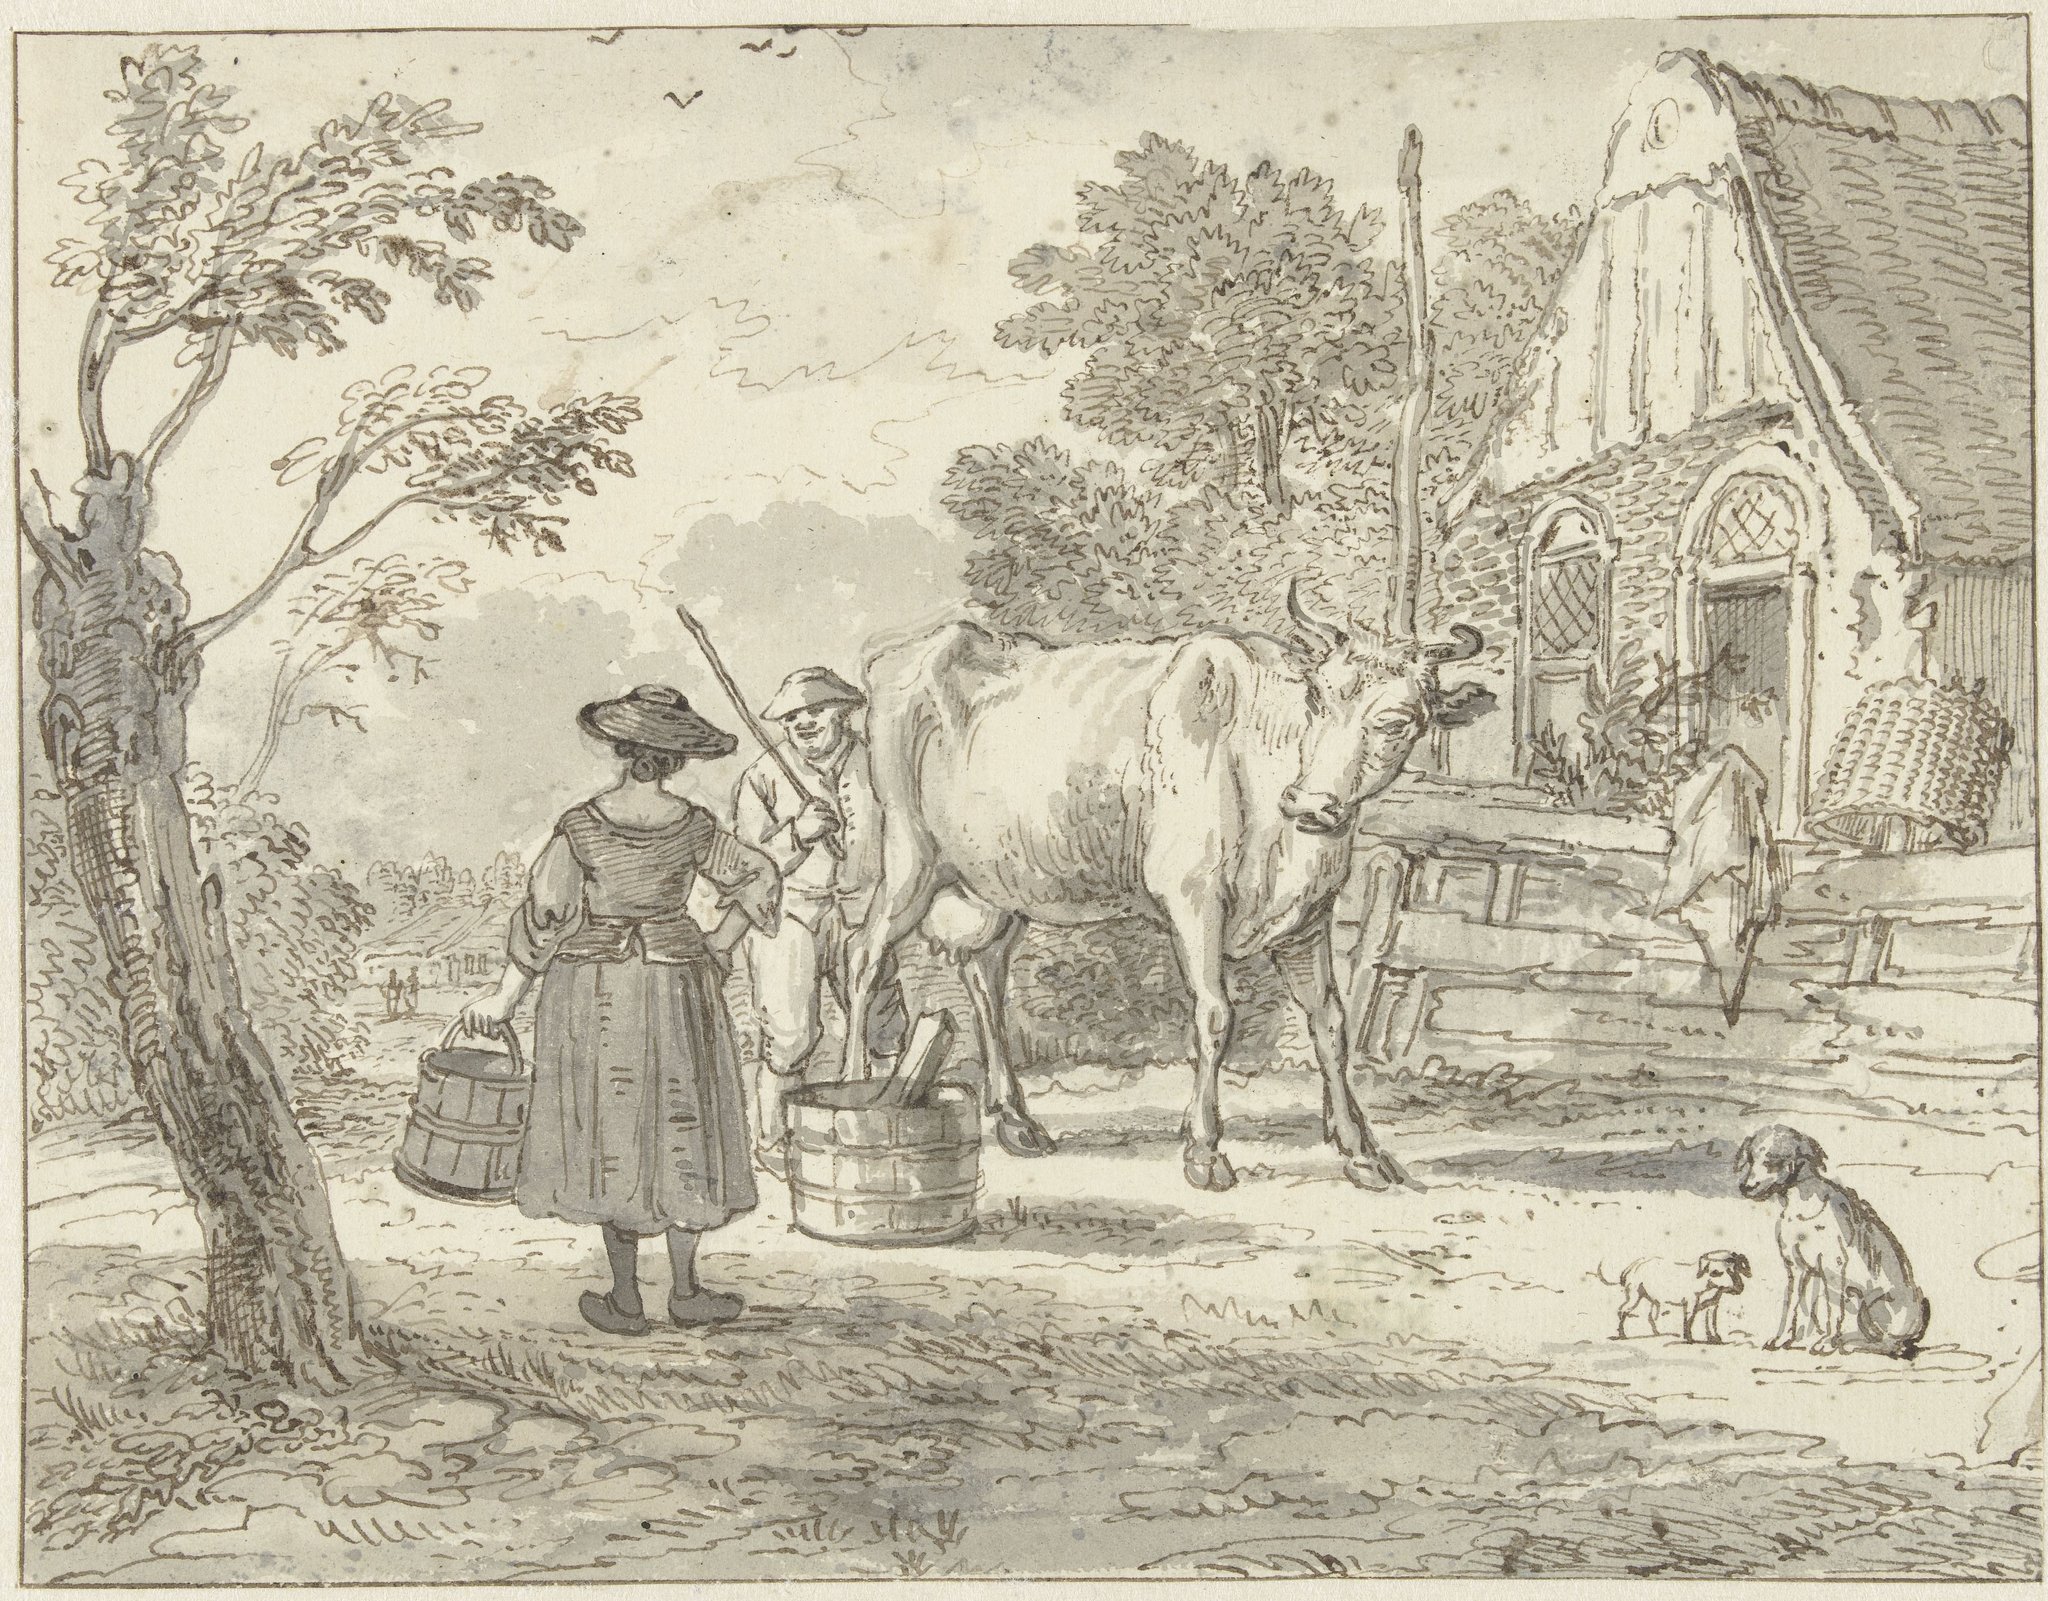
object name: drawing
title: Boeren met een koe voor het huis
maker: paulus constantijn la fargue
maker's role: draughtsman, painter, print maker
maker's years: 1729-1782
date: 1739-1782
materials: ink, paper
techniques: brush, pen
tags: cow